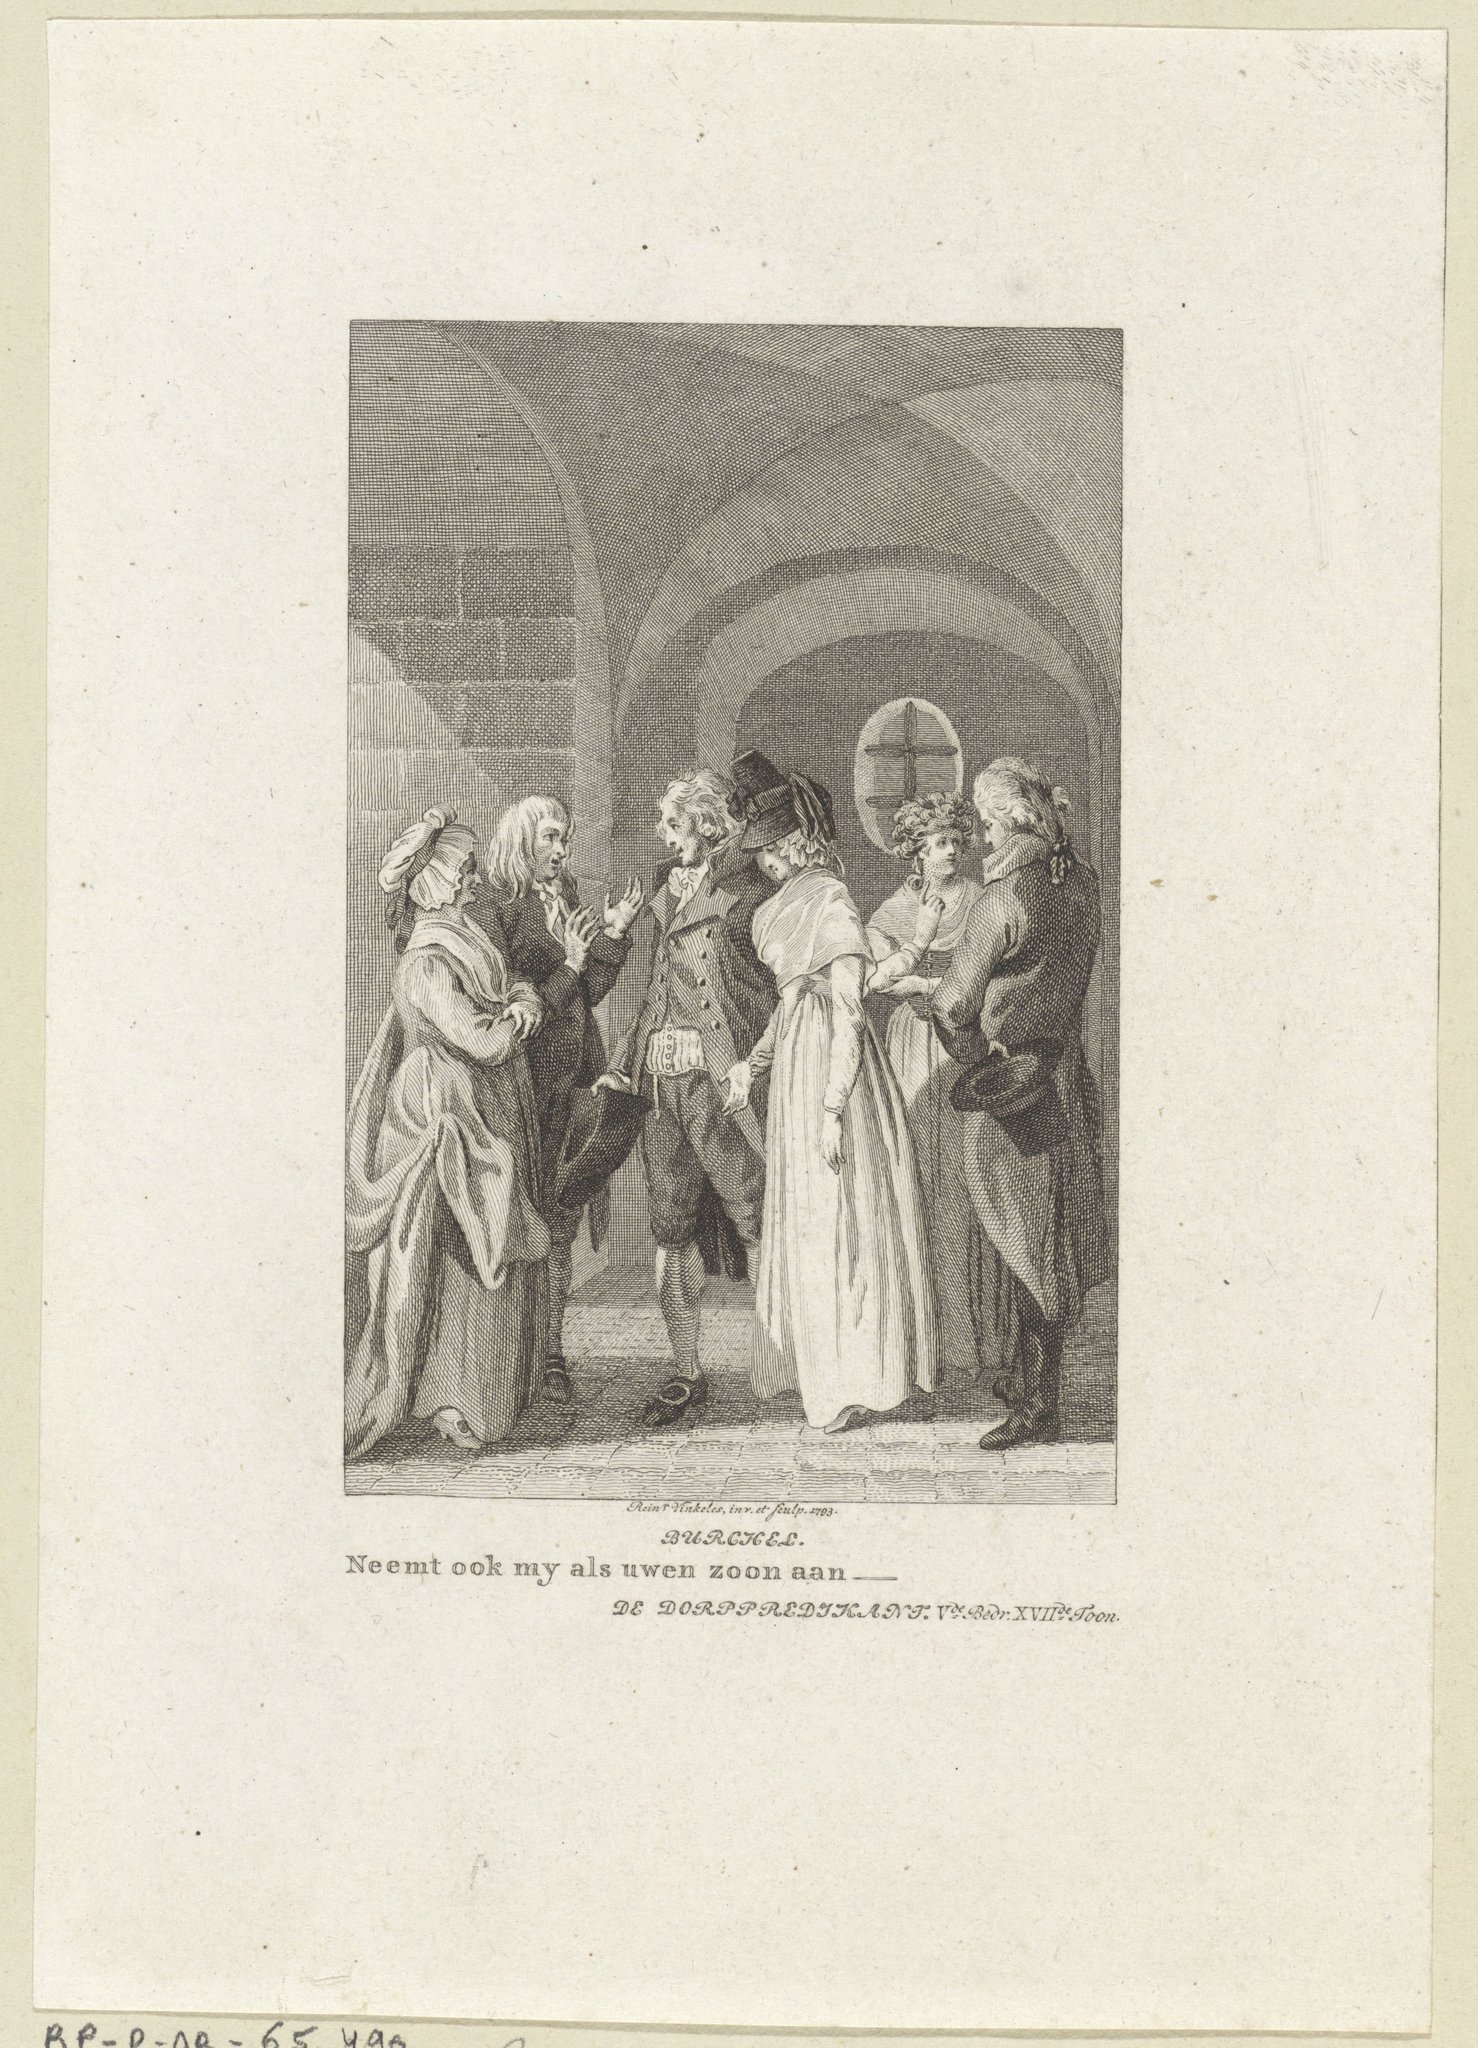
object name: print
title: Twee mannen en twee vrouwen in gesprek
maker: reinier vinkeles (i)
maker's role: draughtsman, print maker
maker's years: 1741-1816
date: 1793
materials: paper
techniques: engraving, etching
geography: amsterdam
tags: conversation, dialogue; conversation piece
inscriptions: collector's mark: Lugt 240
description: Deze prent is mogelijk ook gebruikt als illustratie in: De Dorppredikant. Amsterdam: erven van Pieter Meĳer en Gerrit Warnars, 1793.